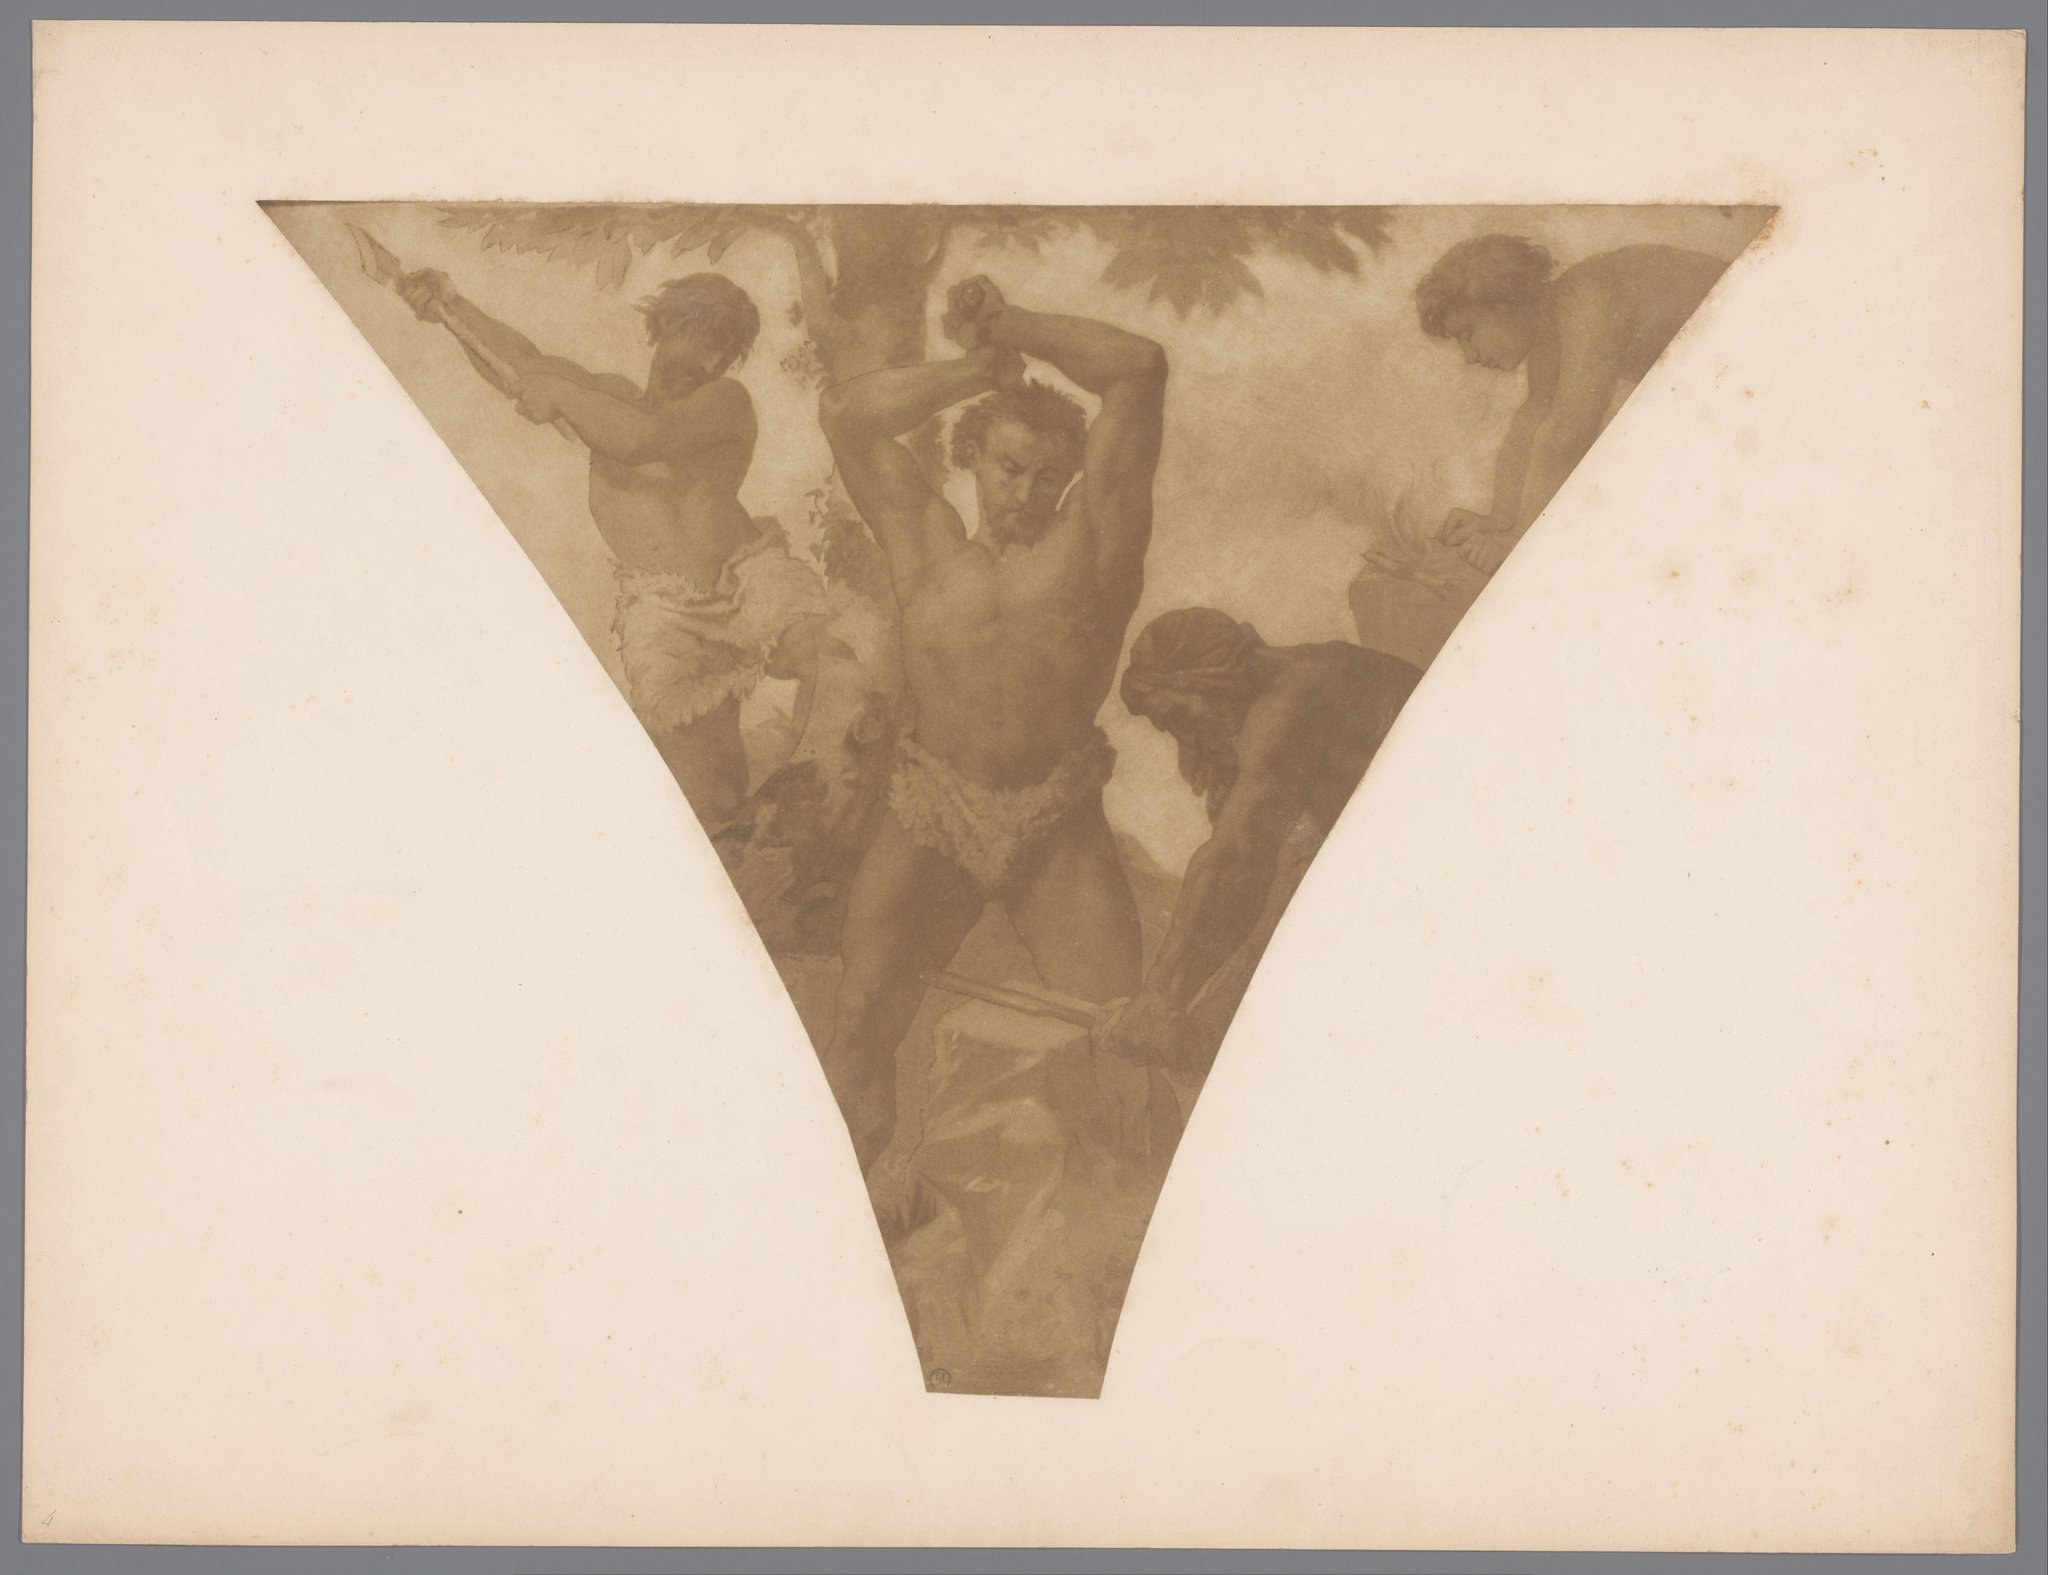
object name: photograph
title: Fotografische reproductie van decoratie aan plafond, Hotel de Ville, Parijs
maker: gustave le gray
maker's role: fotograaf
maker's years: 1820-1884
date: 1852-1853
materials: cardboard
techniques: salted paper print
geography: france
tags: paris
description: Maakt onderdeel uit van een serie van 18 bladen met foto's van de cartons voor de plafondschilderingen door Henri Lehmann voor de Galerie des Fêtes in het Hotel de Ville, Parijs.